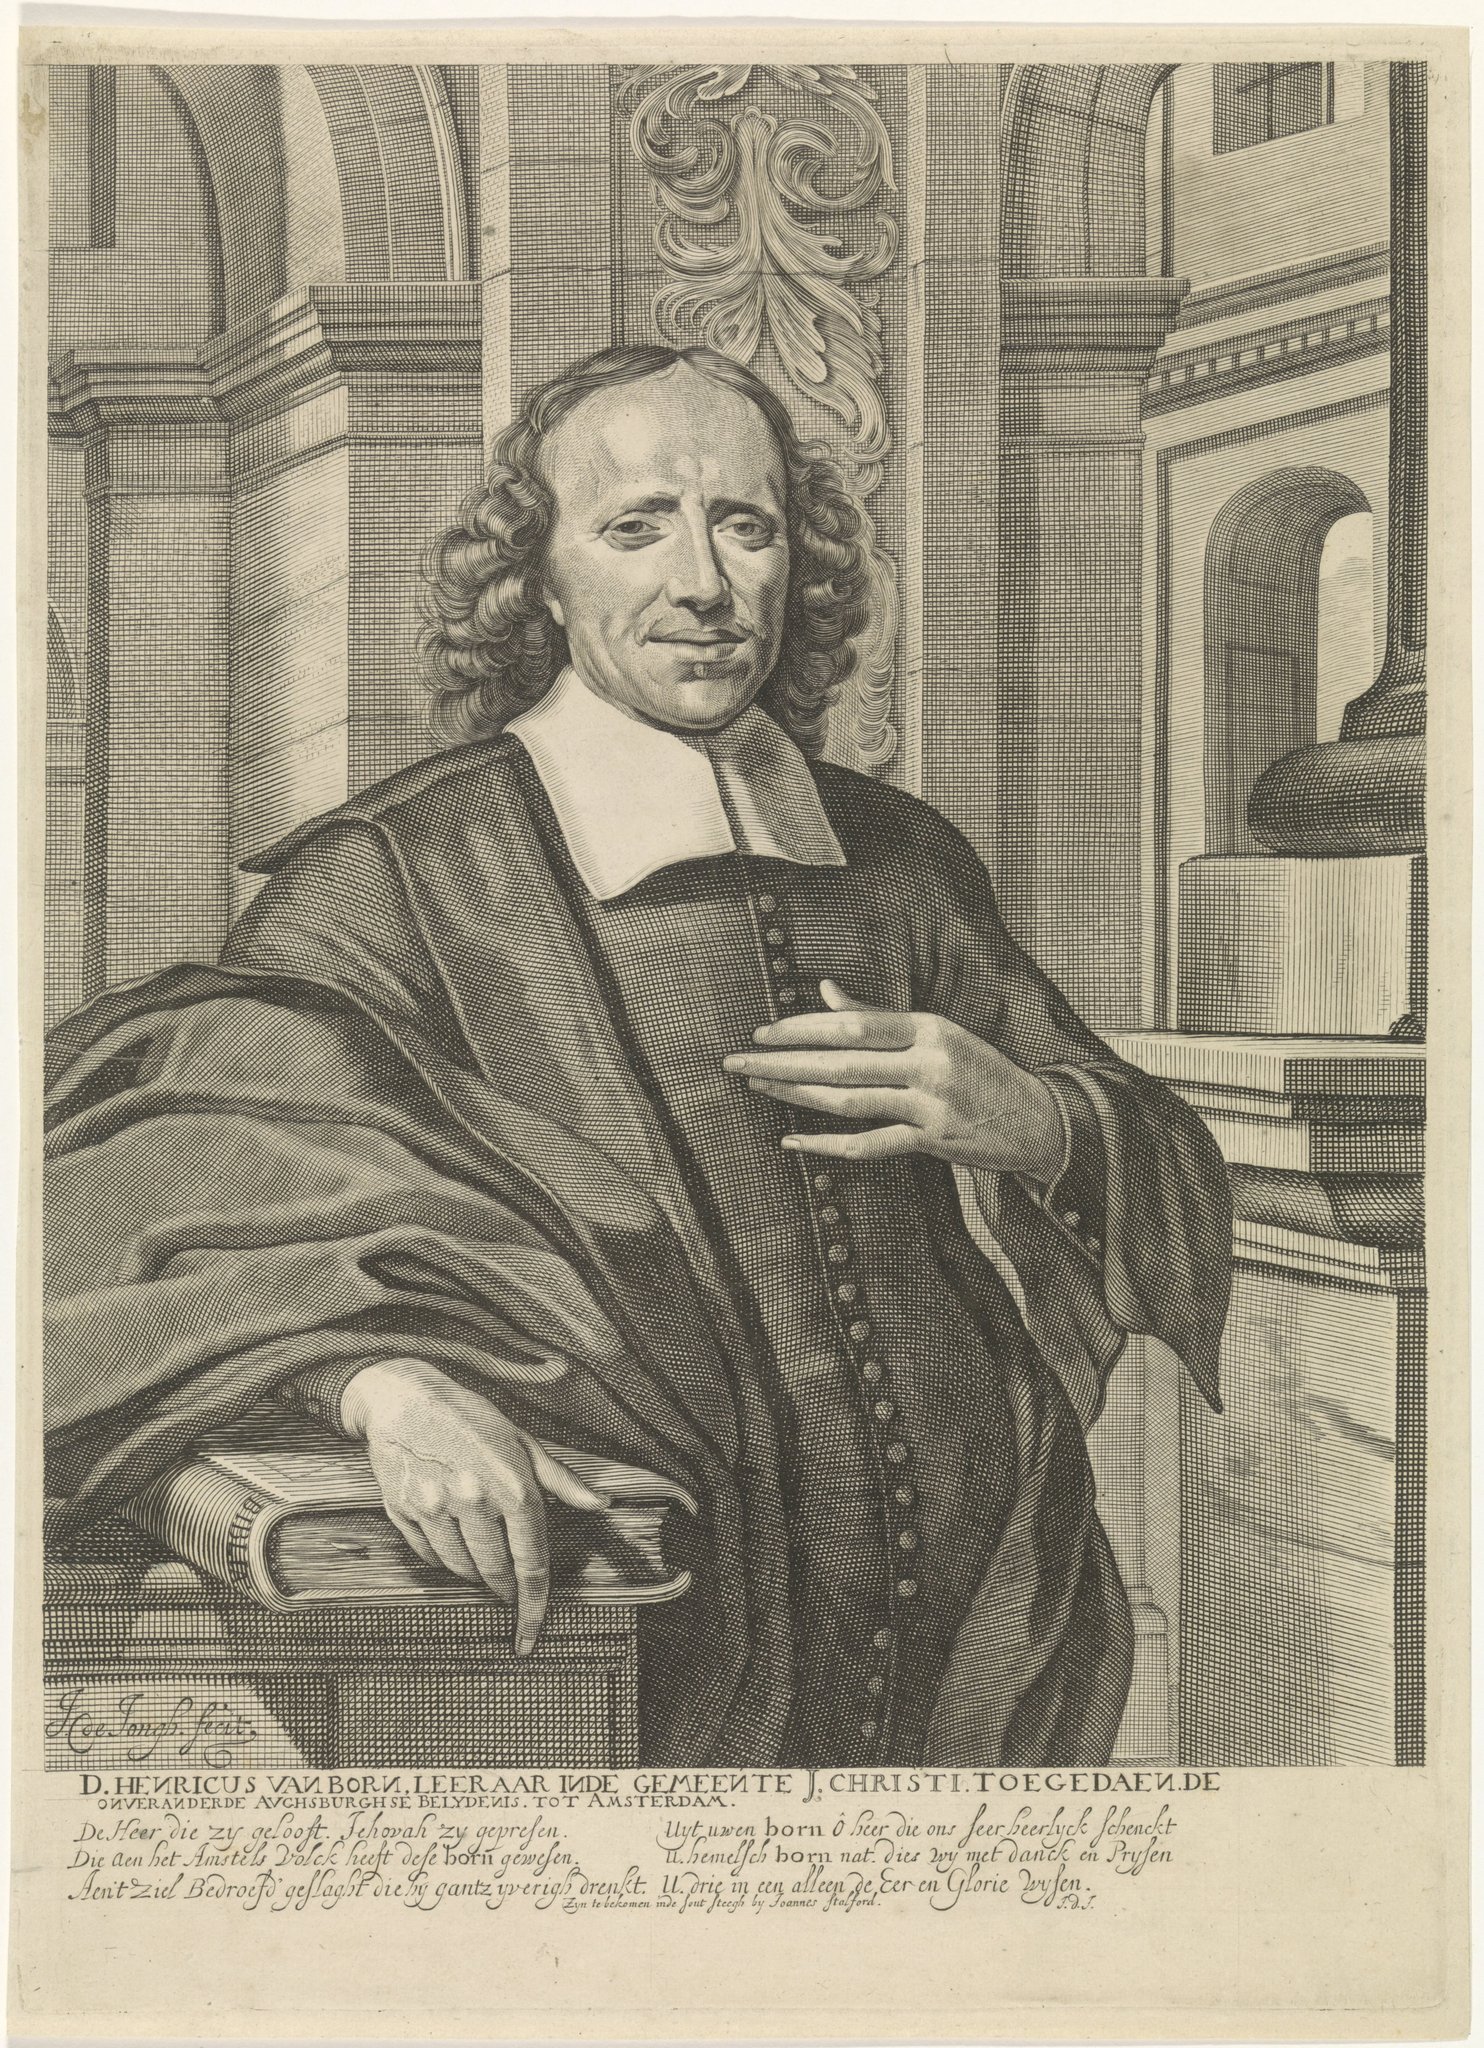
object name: print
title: Portret van Henricus van Born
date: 1677-1684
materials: paper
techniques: engraving, etching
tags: henricus van born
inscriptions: collector's mark: Lugt 2228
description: Portret van de predikant Henricus van Born, staand in een kerk. Zijn linkerhand houdt hij tegen zijn borst en met zijn rechterhand rust hij op de bijbel. In de marge een tweeregelig onderschrift in het Nederlands en een zesregelig gedicht, in twee kolommen, in het Nederlands.